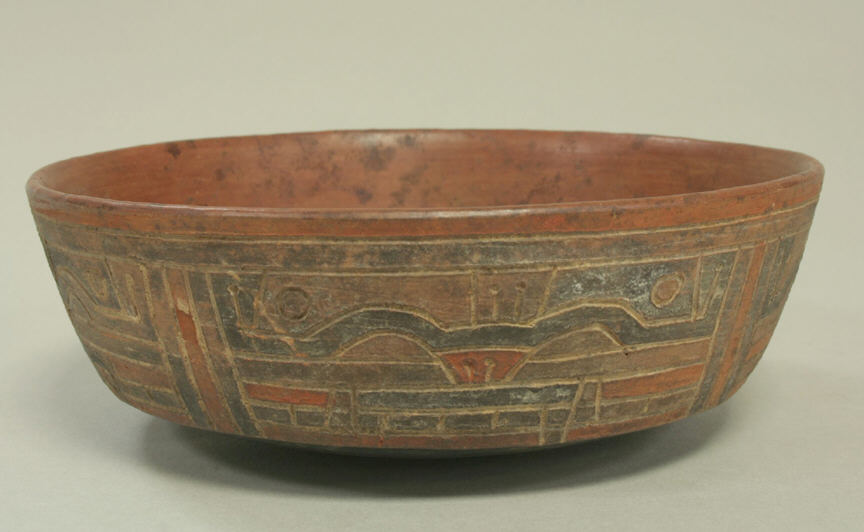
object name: bowl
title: Painted Bowl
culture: paracas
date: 700-401 BCE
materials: ceramic, pigment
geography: peru